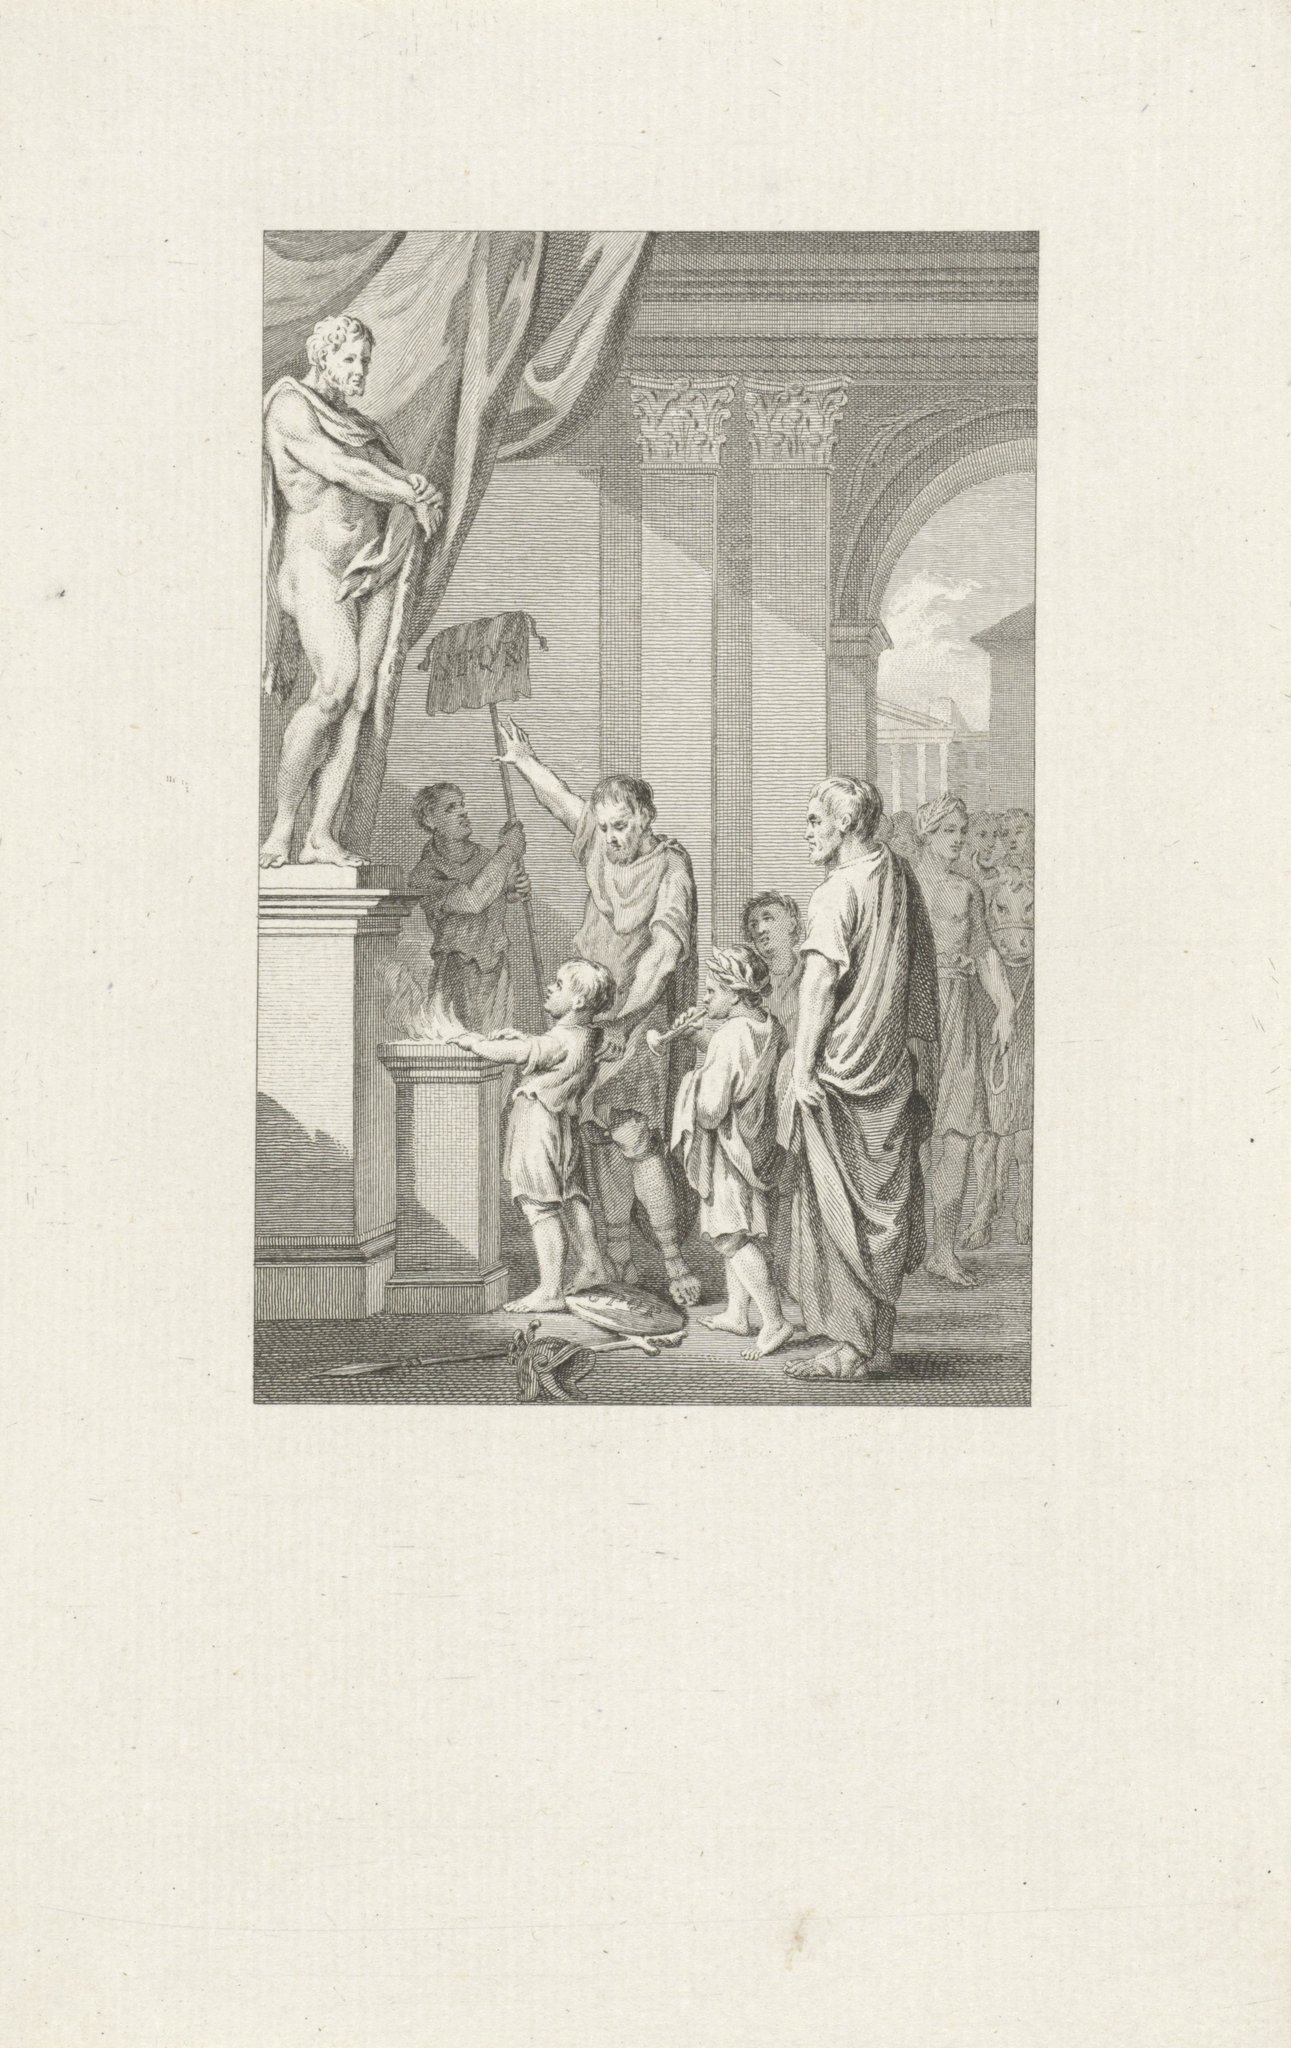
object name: print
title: Hannibal als kind zweert tegen de Romeinen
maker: reinier vinkeles (i)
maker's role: draughtsman, print maker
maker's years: 1741-1816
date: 1780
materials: paper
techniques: engraving, etching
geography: amsterdam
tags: swearing allegiance to a ruler (+ variant), altar ~ non-christian religions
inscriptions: collector's mark: Lugt 240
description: Latere staat prent gebruikt als boekillustratie in: Martinet, Joannes Florentius. Historie der waereld. Amsterdam: Johannes Allart, 1780-1788. 25 delen. deel I, pl. IV.